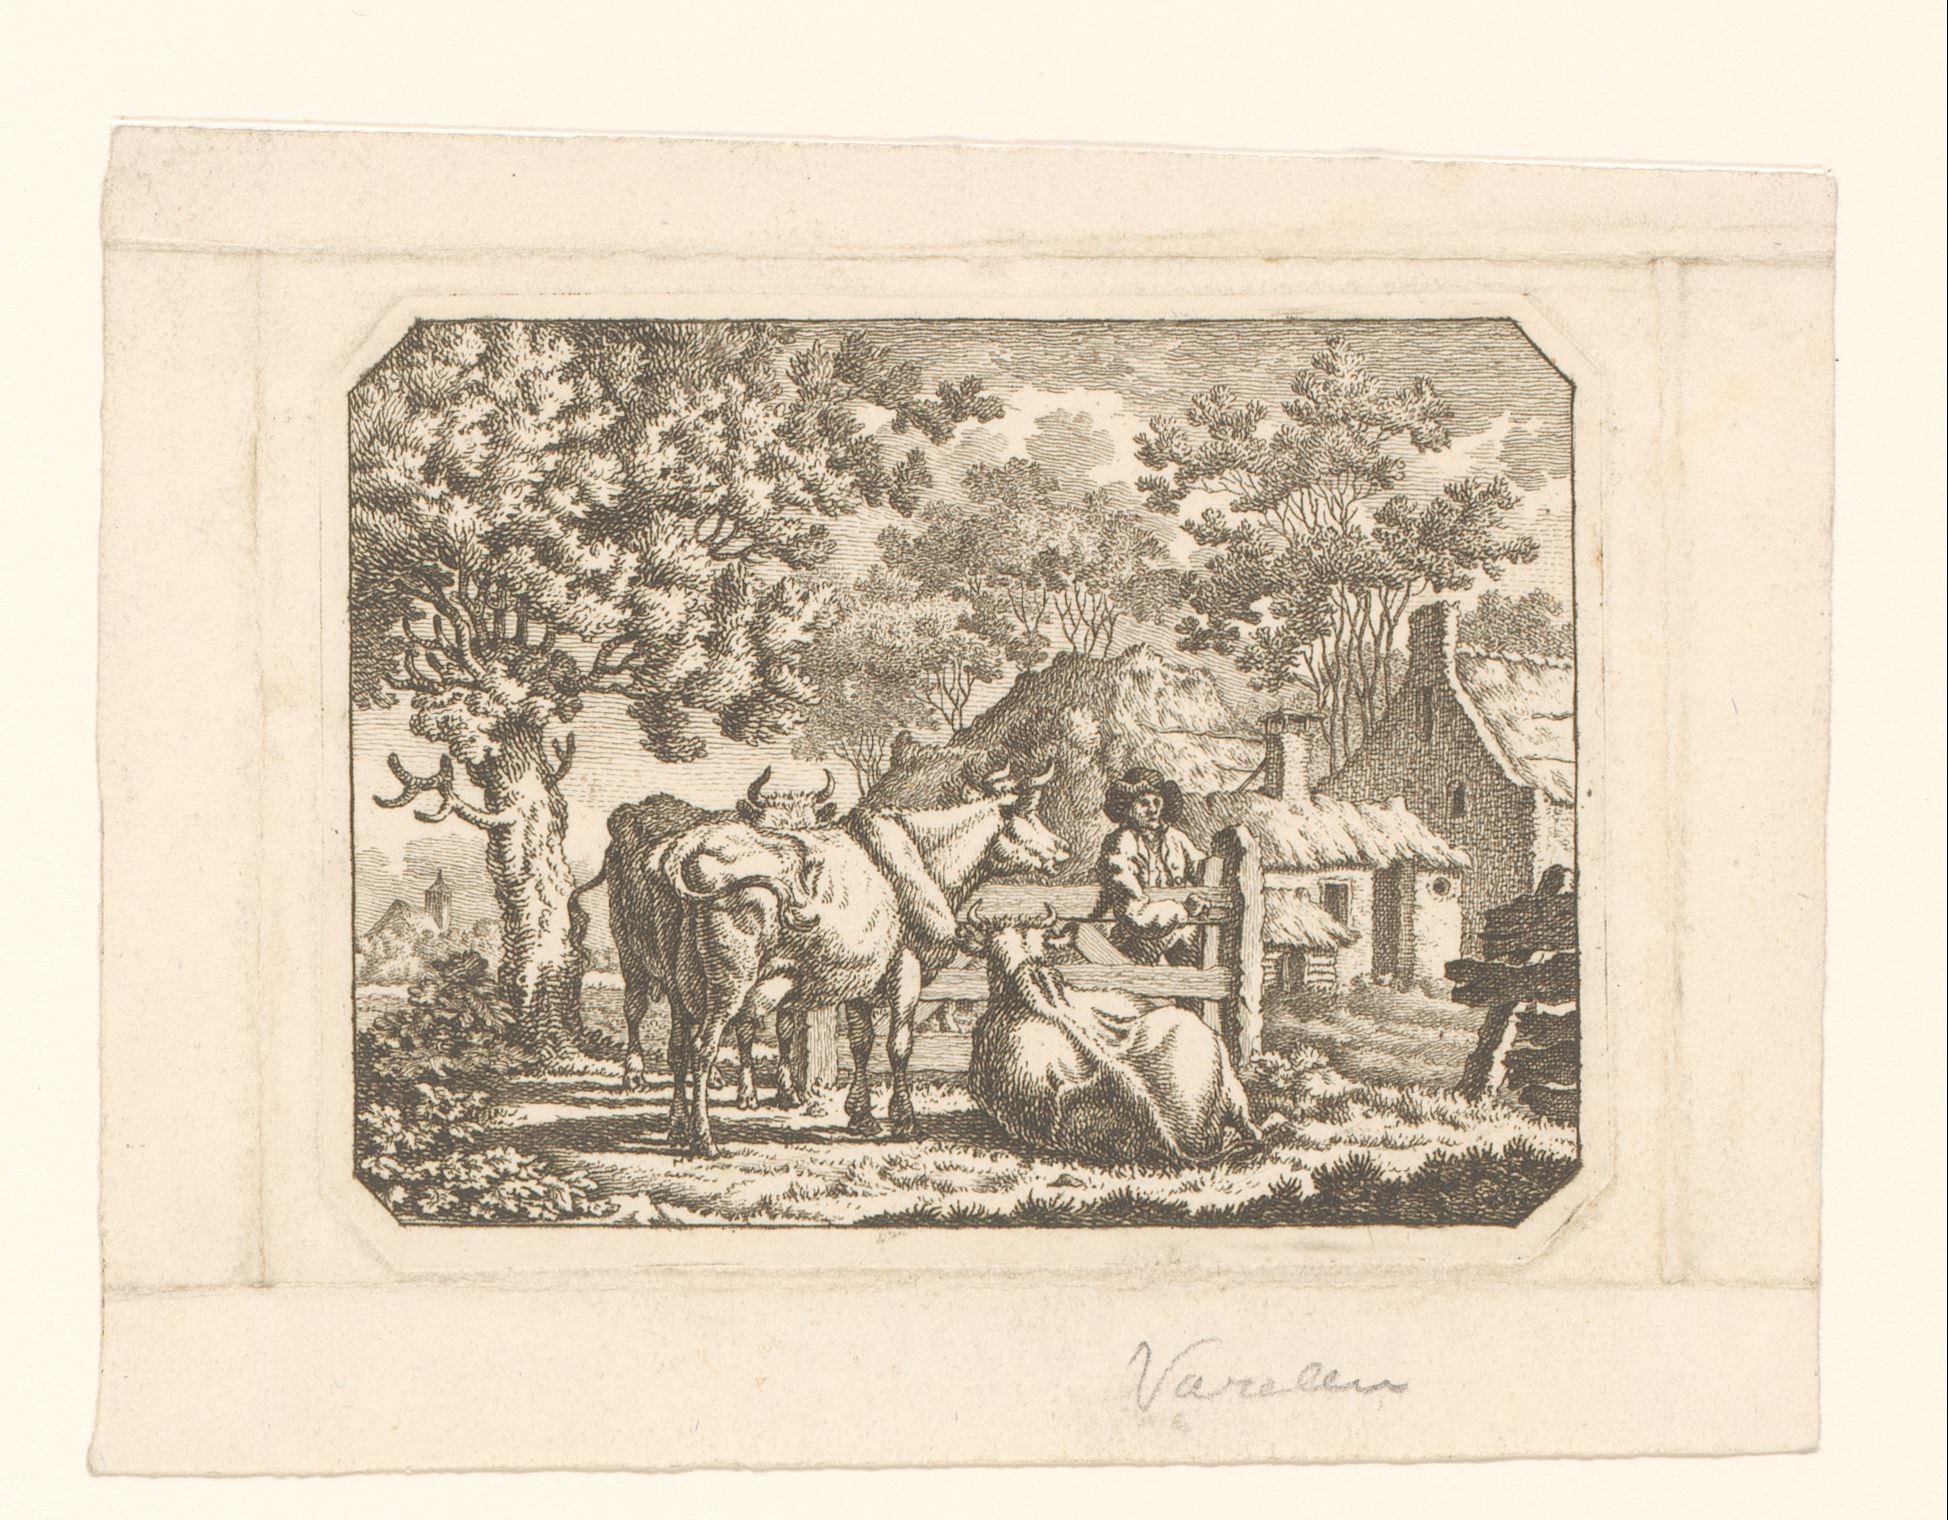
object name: print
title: Drie koeien bij een boer aan een hek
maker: jacob elias van varelen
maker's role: draughtsman, print maker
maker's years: 1757-1840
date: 1818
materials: paper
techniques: etching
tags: cow, farm or solitary house in landscape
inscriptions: inscription: ‘H. 354’, collector's mark: Lugt 2228